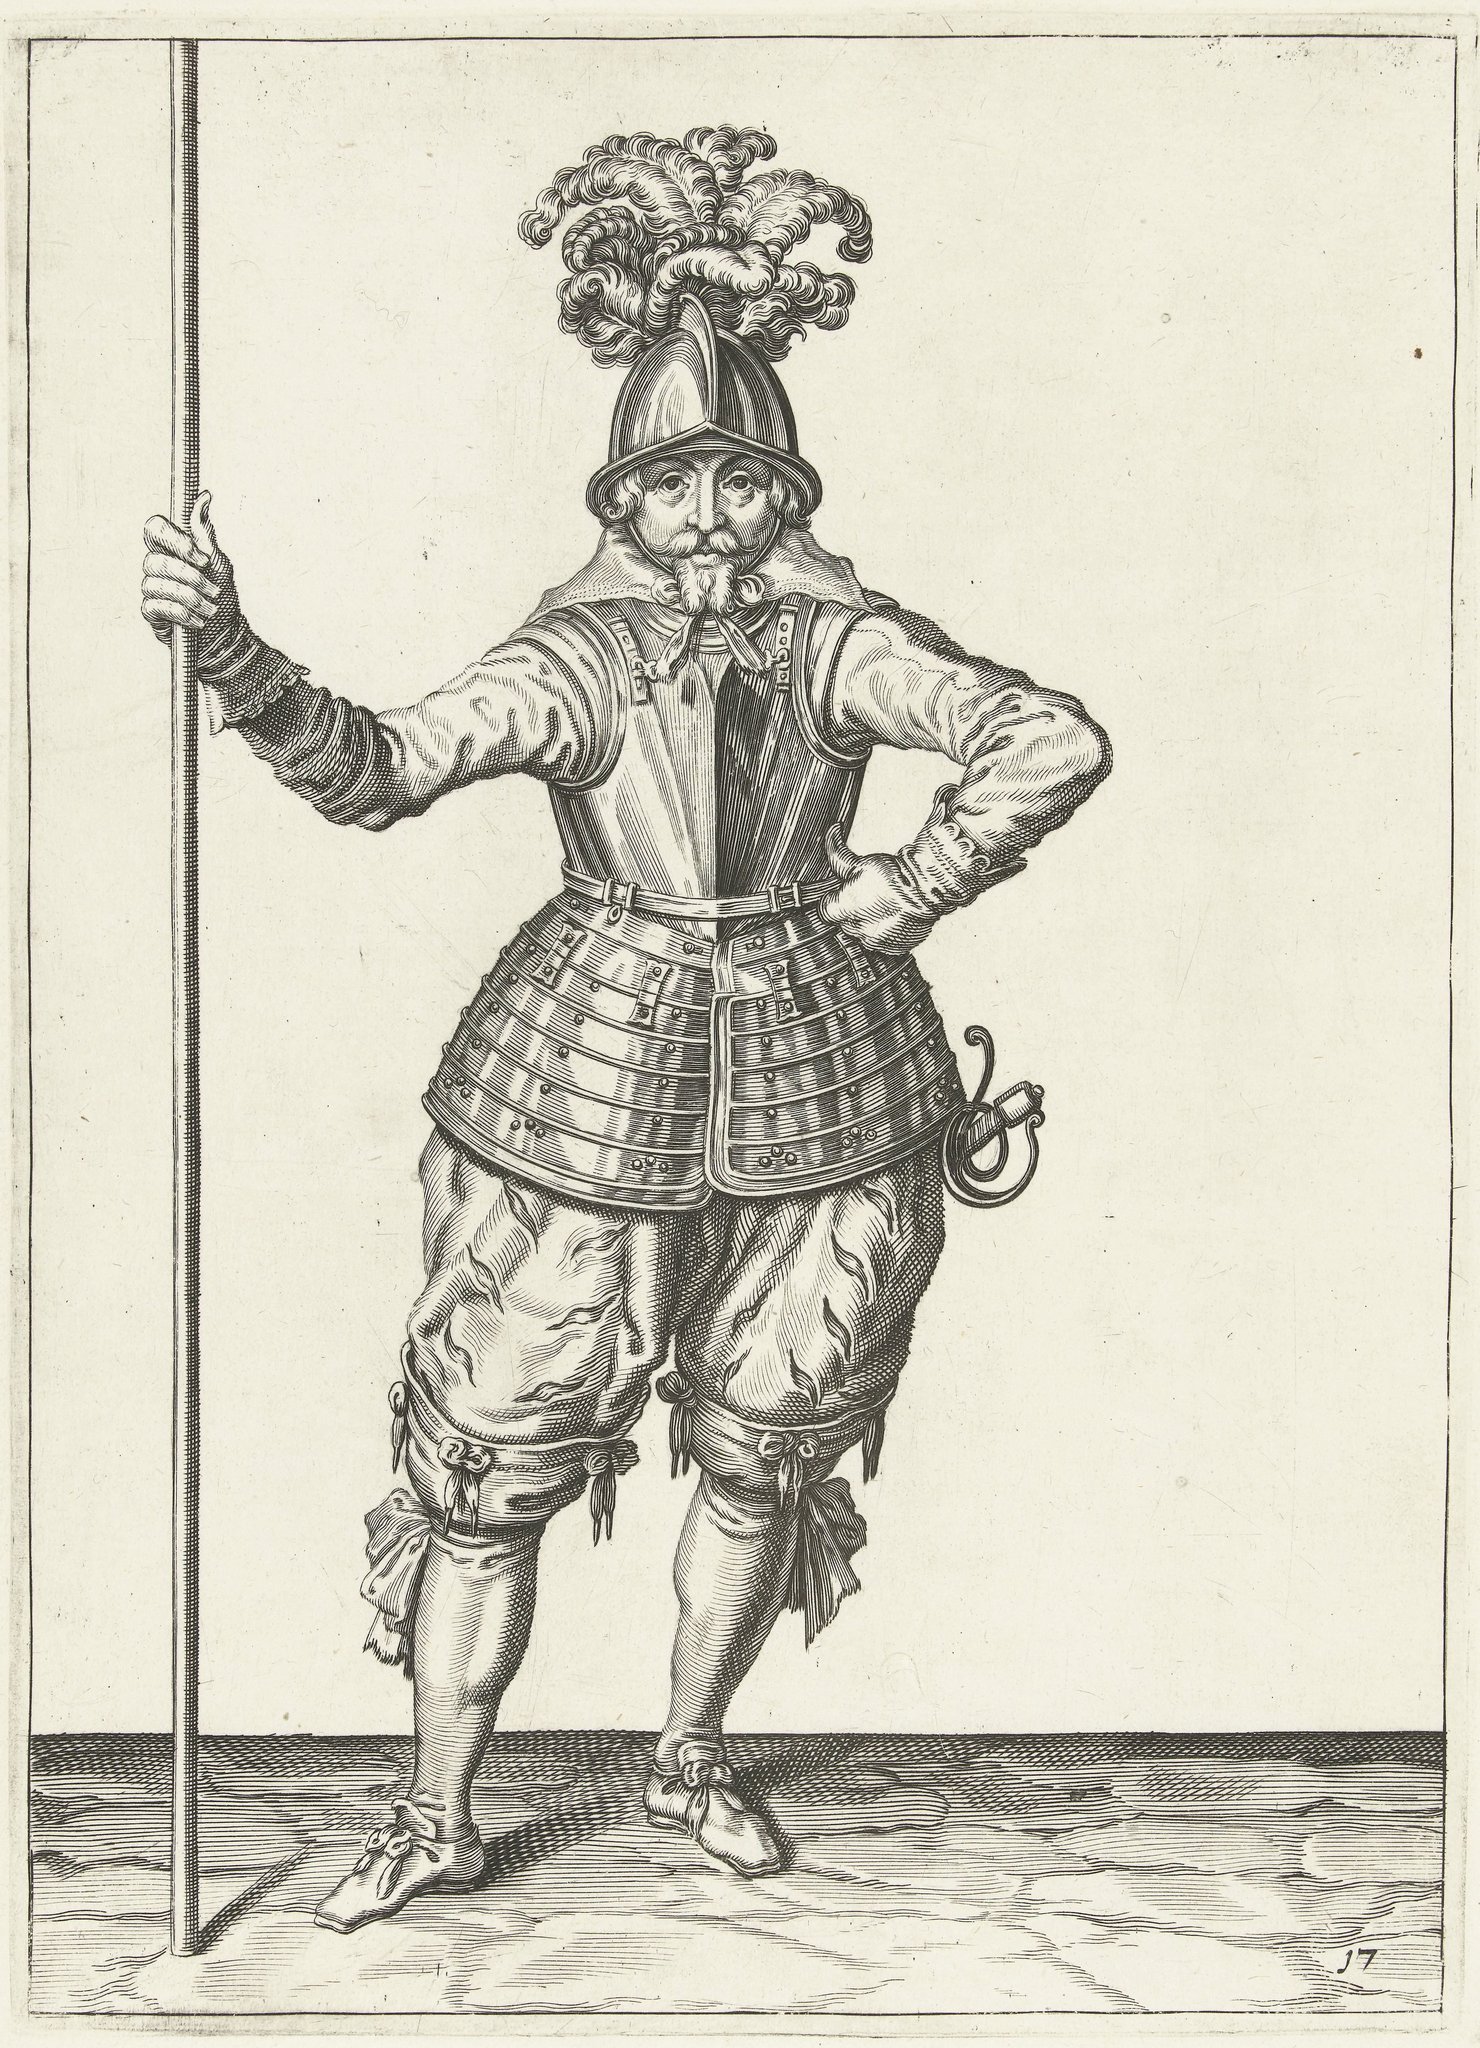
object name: print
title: Wapenhandelinghe van Roers Musquetten ende Spiessen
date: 1597-1607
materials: paper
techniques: engraving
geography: netherlands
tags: manoeuvre ~ military training, warfare; military affairs (+ mercenary troops, e.g.: lansquenets), helved weapons, polearms (for striking, hacking, thrusting): lance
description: Een soldaat, ten voeten uit, die een spies (lans) met zijn rechterhand rechtop vasthoudt. Deze prent is onderdeel van de reeks van 32 genummerde prenten van spiesdragers uit de Wapenhandelinghe.